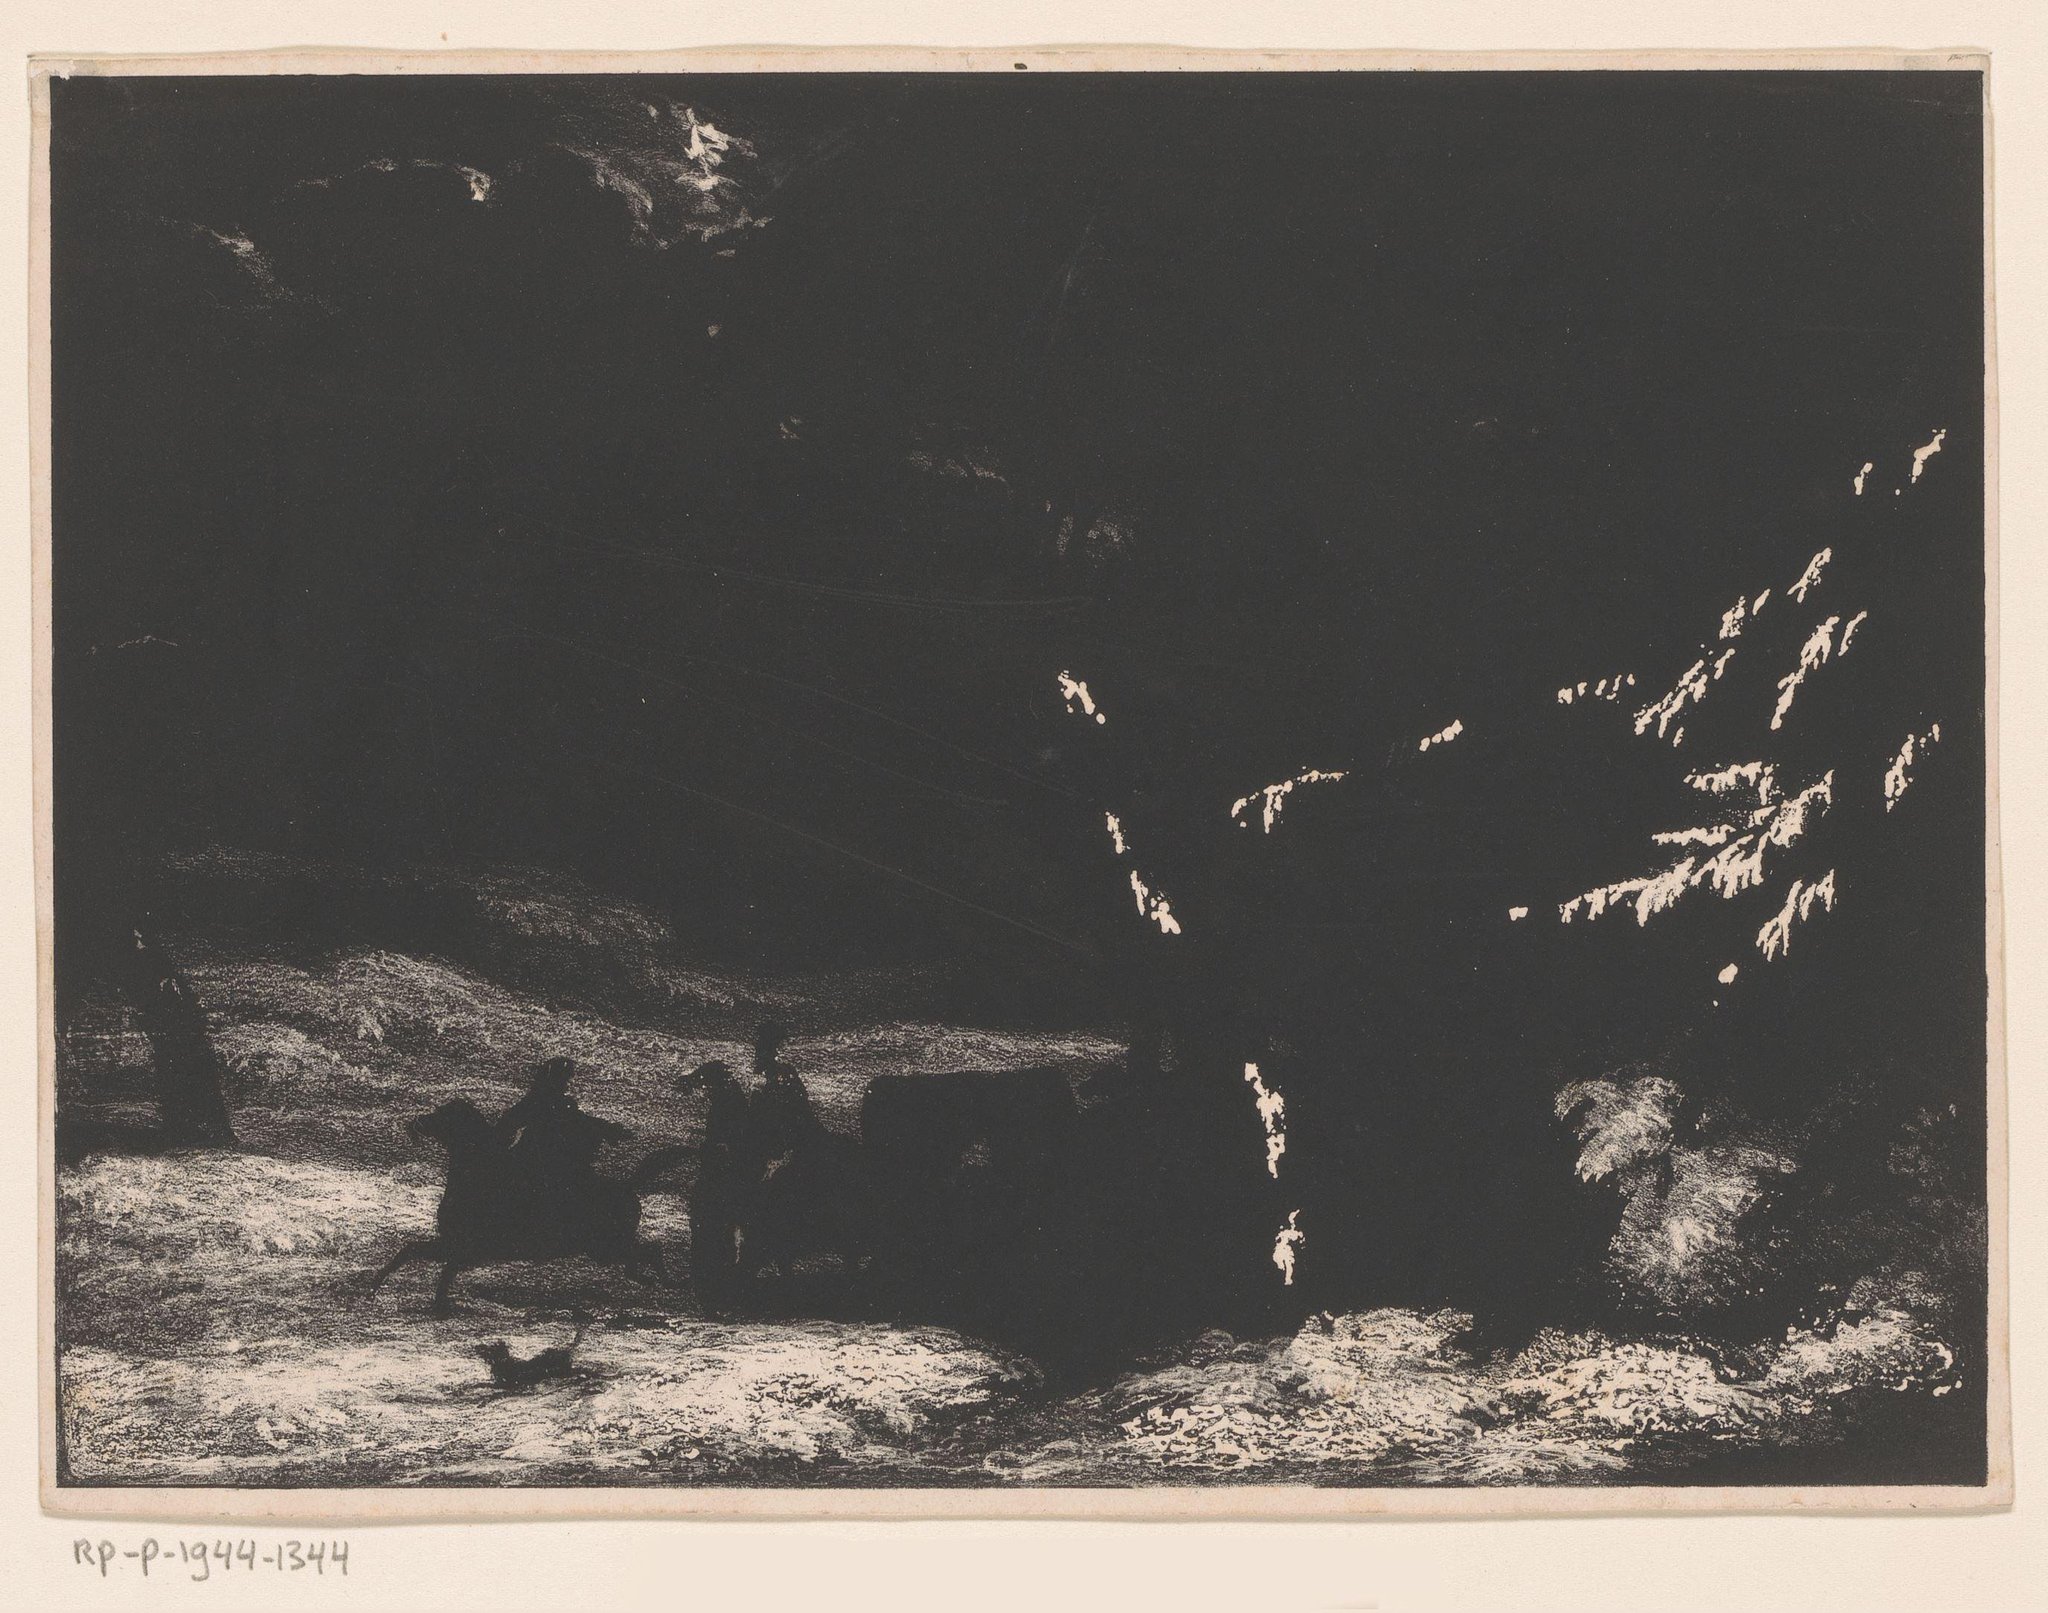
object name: print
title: Landschap met ruiters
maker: Anonymous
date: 1850-1900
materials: paper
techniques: lithograph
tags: riding a horse, ass, or mule; rider, horseman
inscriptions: collector's mark: Lugt 2228, caption: ‘2den steen. Zeer grof gegreind, zoo als hier goed te zien is. [...] maar het grein moet overal gelijk zijn [...]’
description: Onder de prent is een handgeschreven onderschrift met uitleg over de gebruikte techniek geplakt.